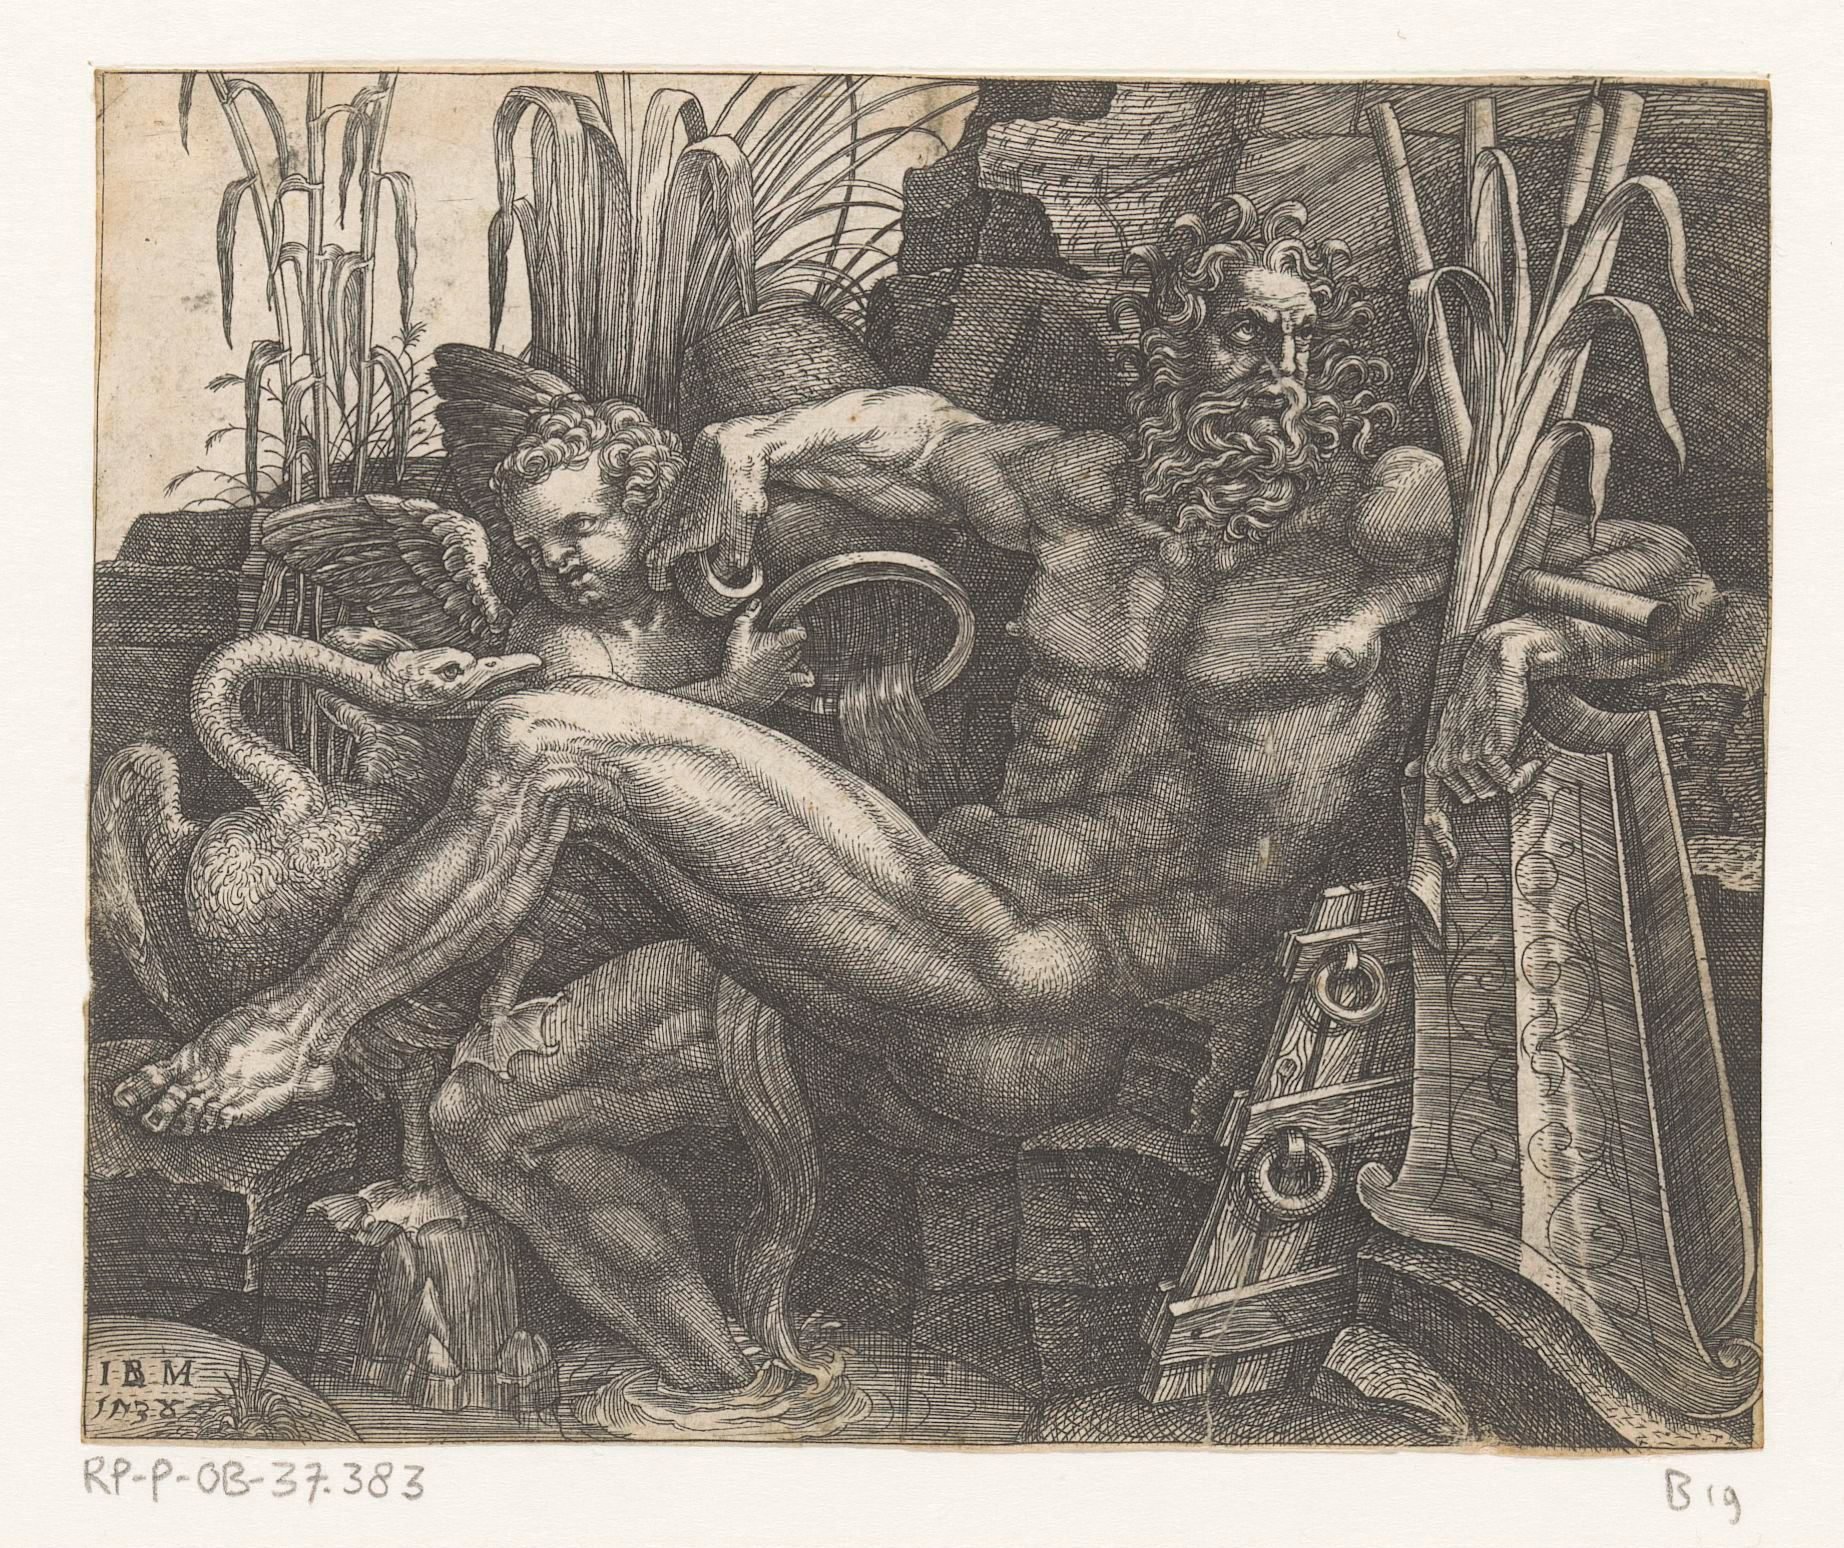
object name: print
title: Riviergod Po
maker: giovanni battista scultori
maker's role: print maker, sculptor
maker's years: 1503-1575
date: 1538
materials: paper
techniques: engraving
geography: italy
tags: water-birds: swan, personification of river po; 'po' (ripa)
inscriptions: collector's mark: Lugt 240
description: De riviergod Po zittend met naast hem een putto en een zwaan.